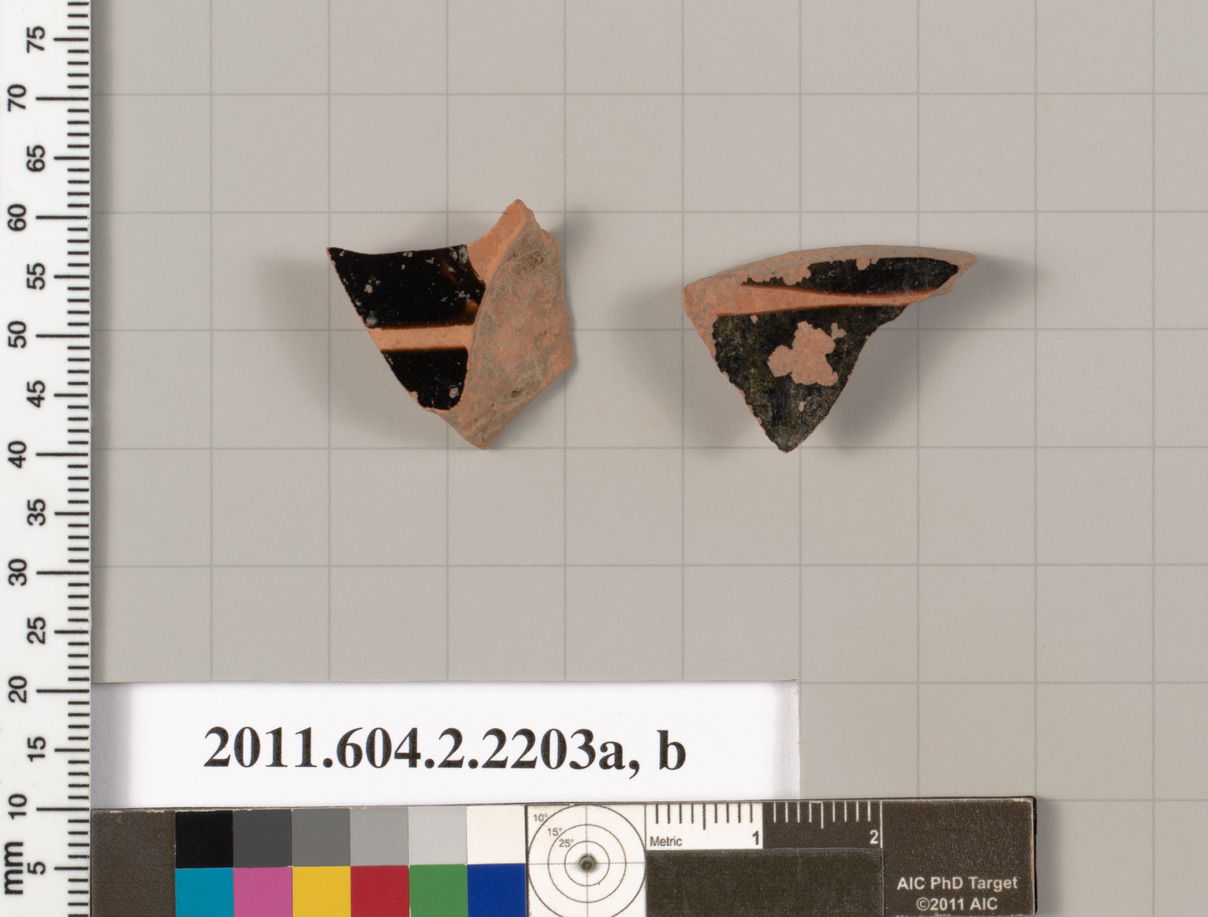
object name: pot fragment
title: Terracotta fragments of pots; unglazed on the inside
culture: greek, attic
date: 450-426 BCE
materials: terracotta